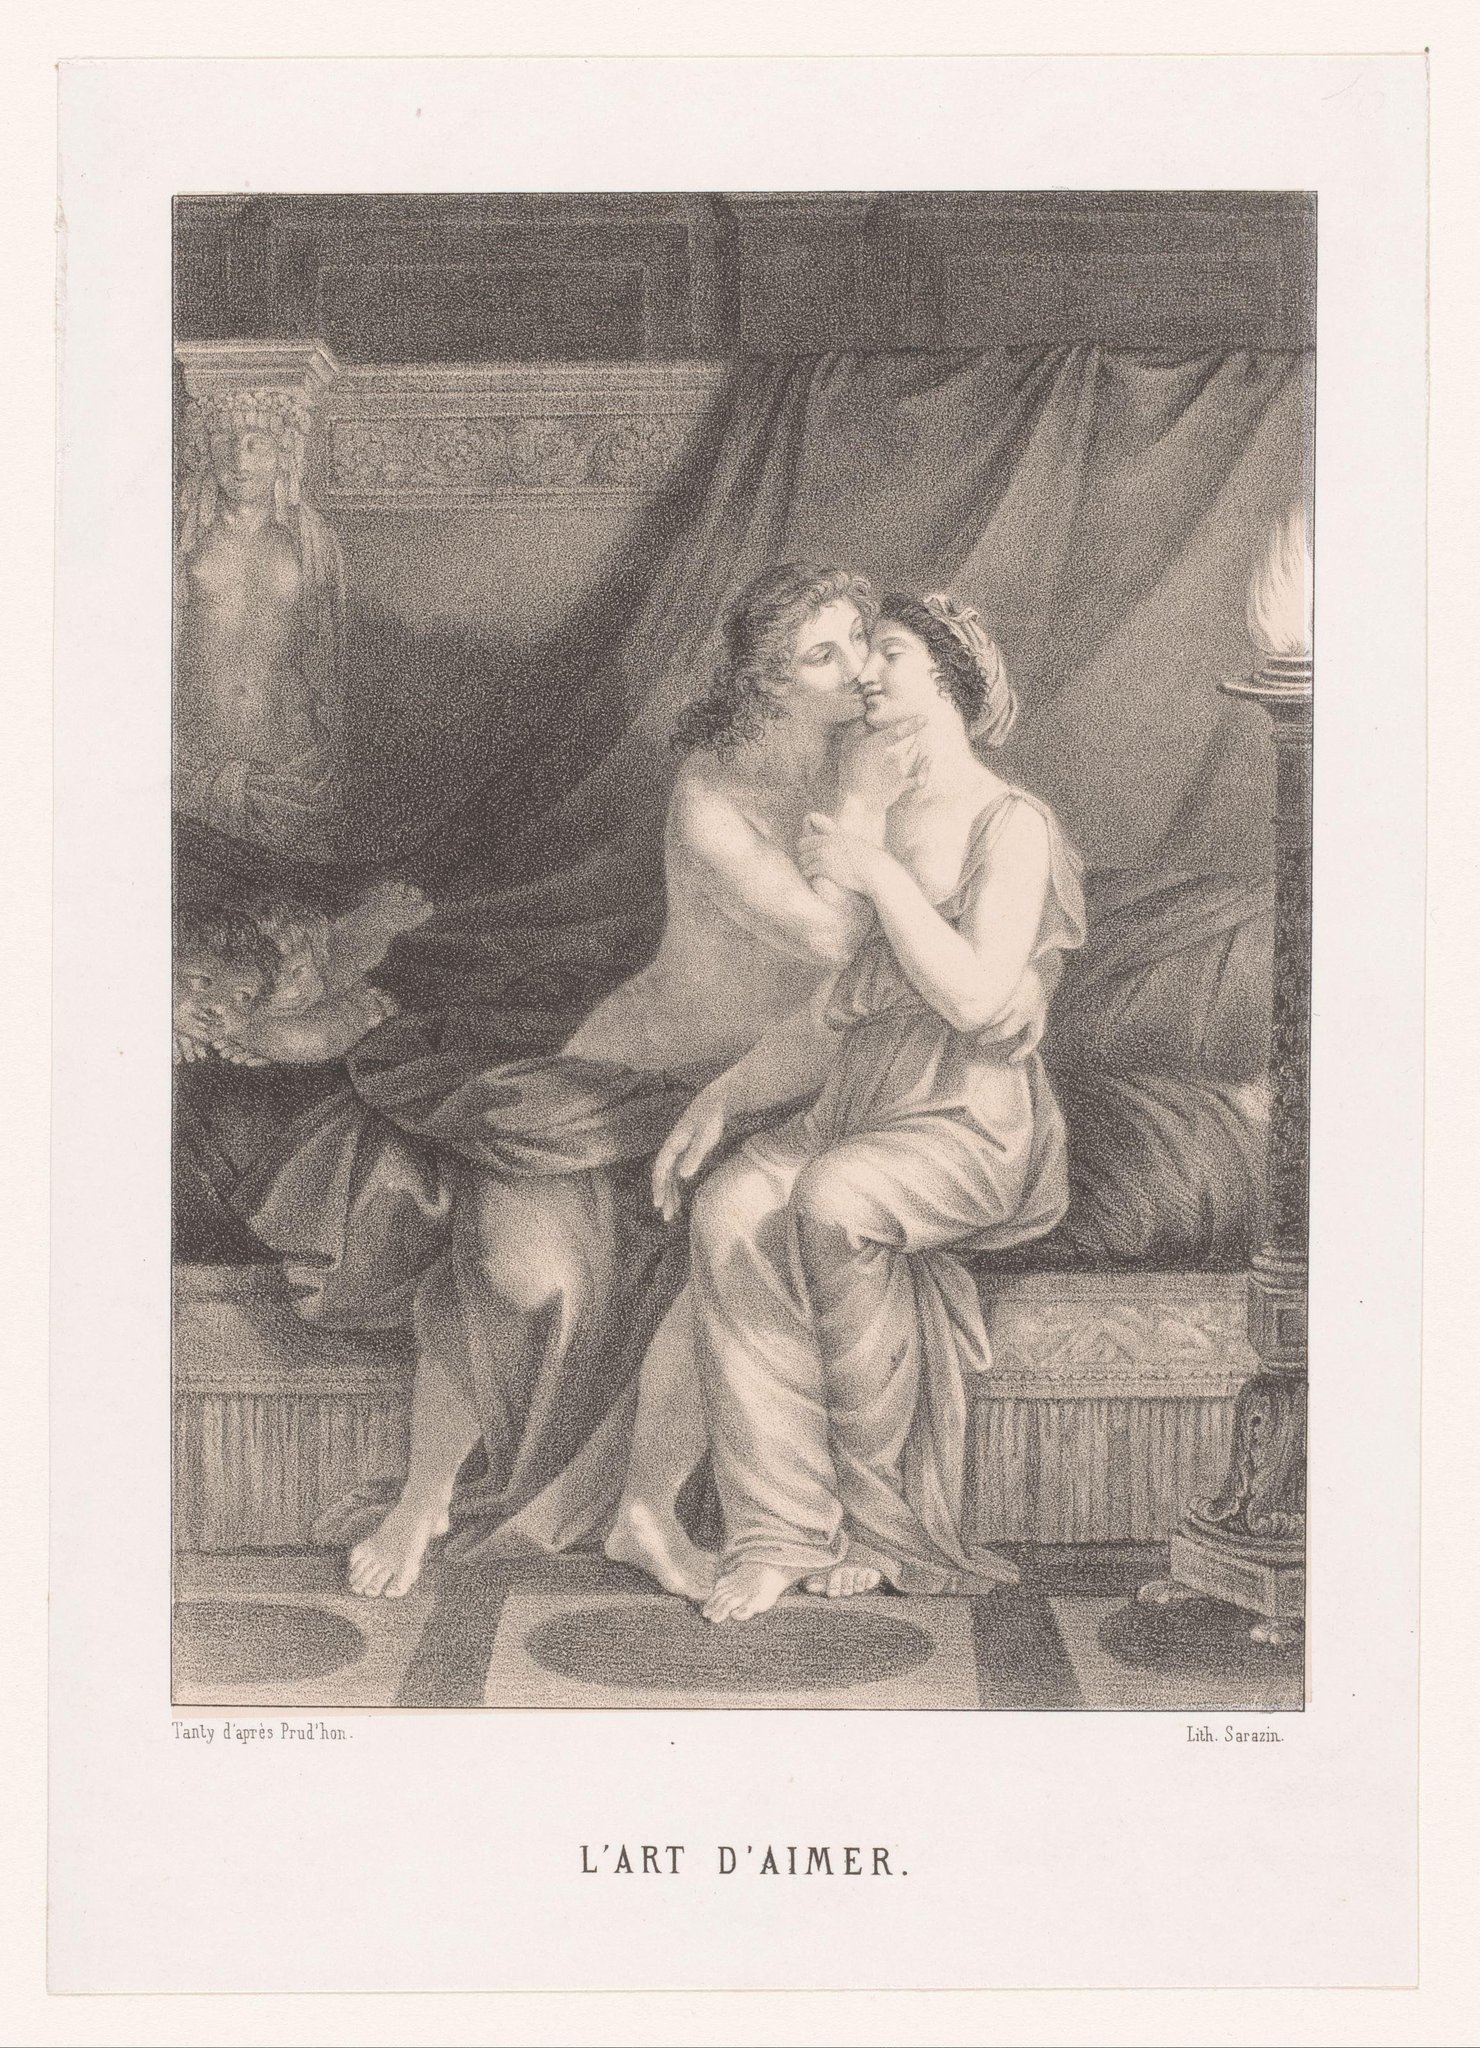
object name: print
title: Verliefd paar zittend op bed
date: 1846-1880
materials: paper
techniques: lithograph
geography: paris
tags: (lovers) caressing each other, cupids: 'amores', 'amoretti', 'putti'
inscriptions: collector's mark: Lugt 2228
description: Scène uit het gedicht 'L'Art d'aimer' van Pierre-Joseph Bernard.